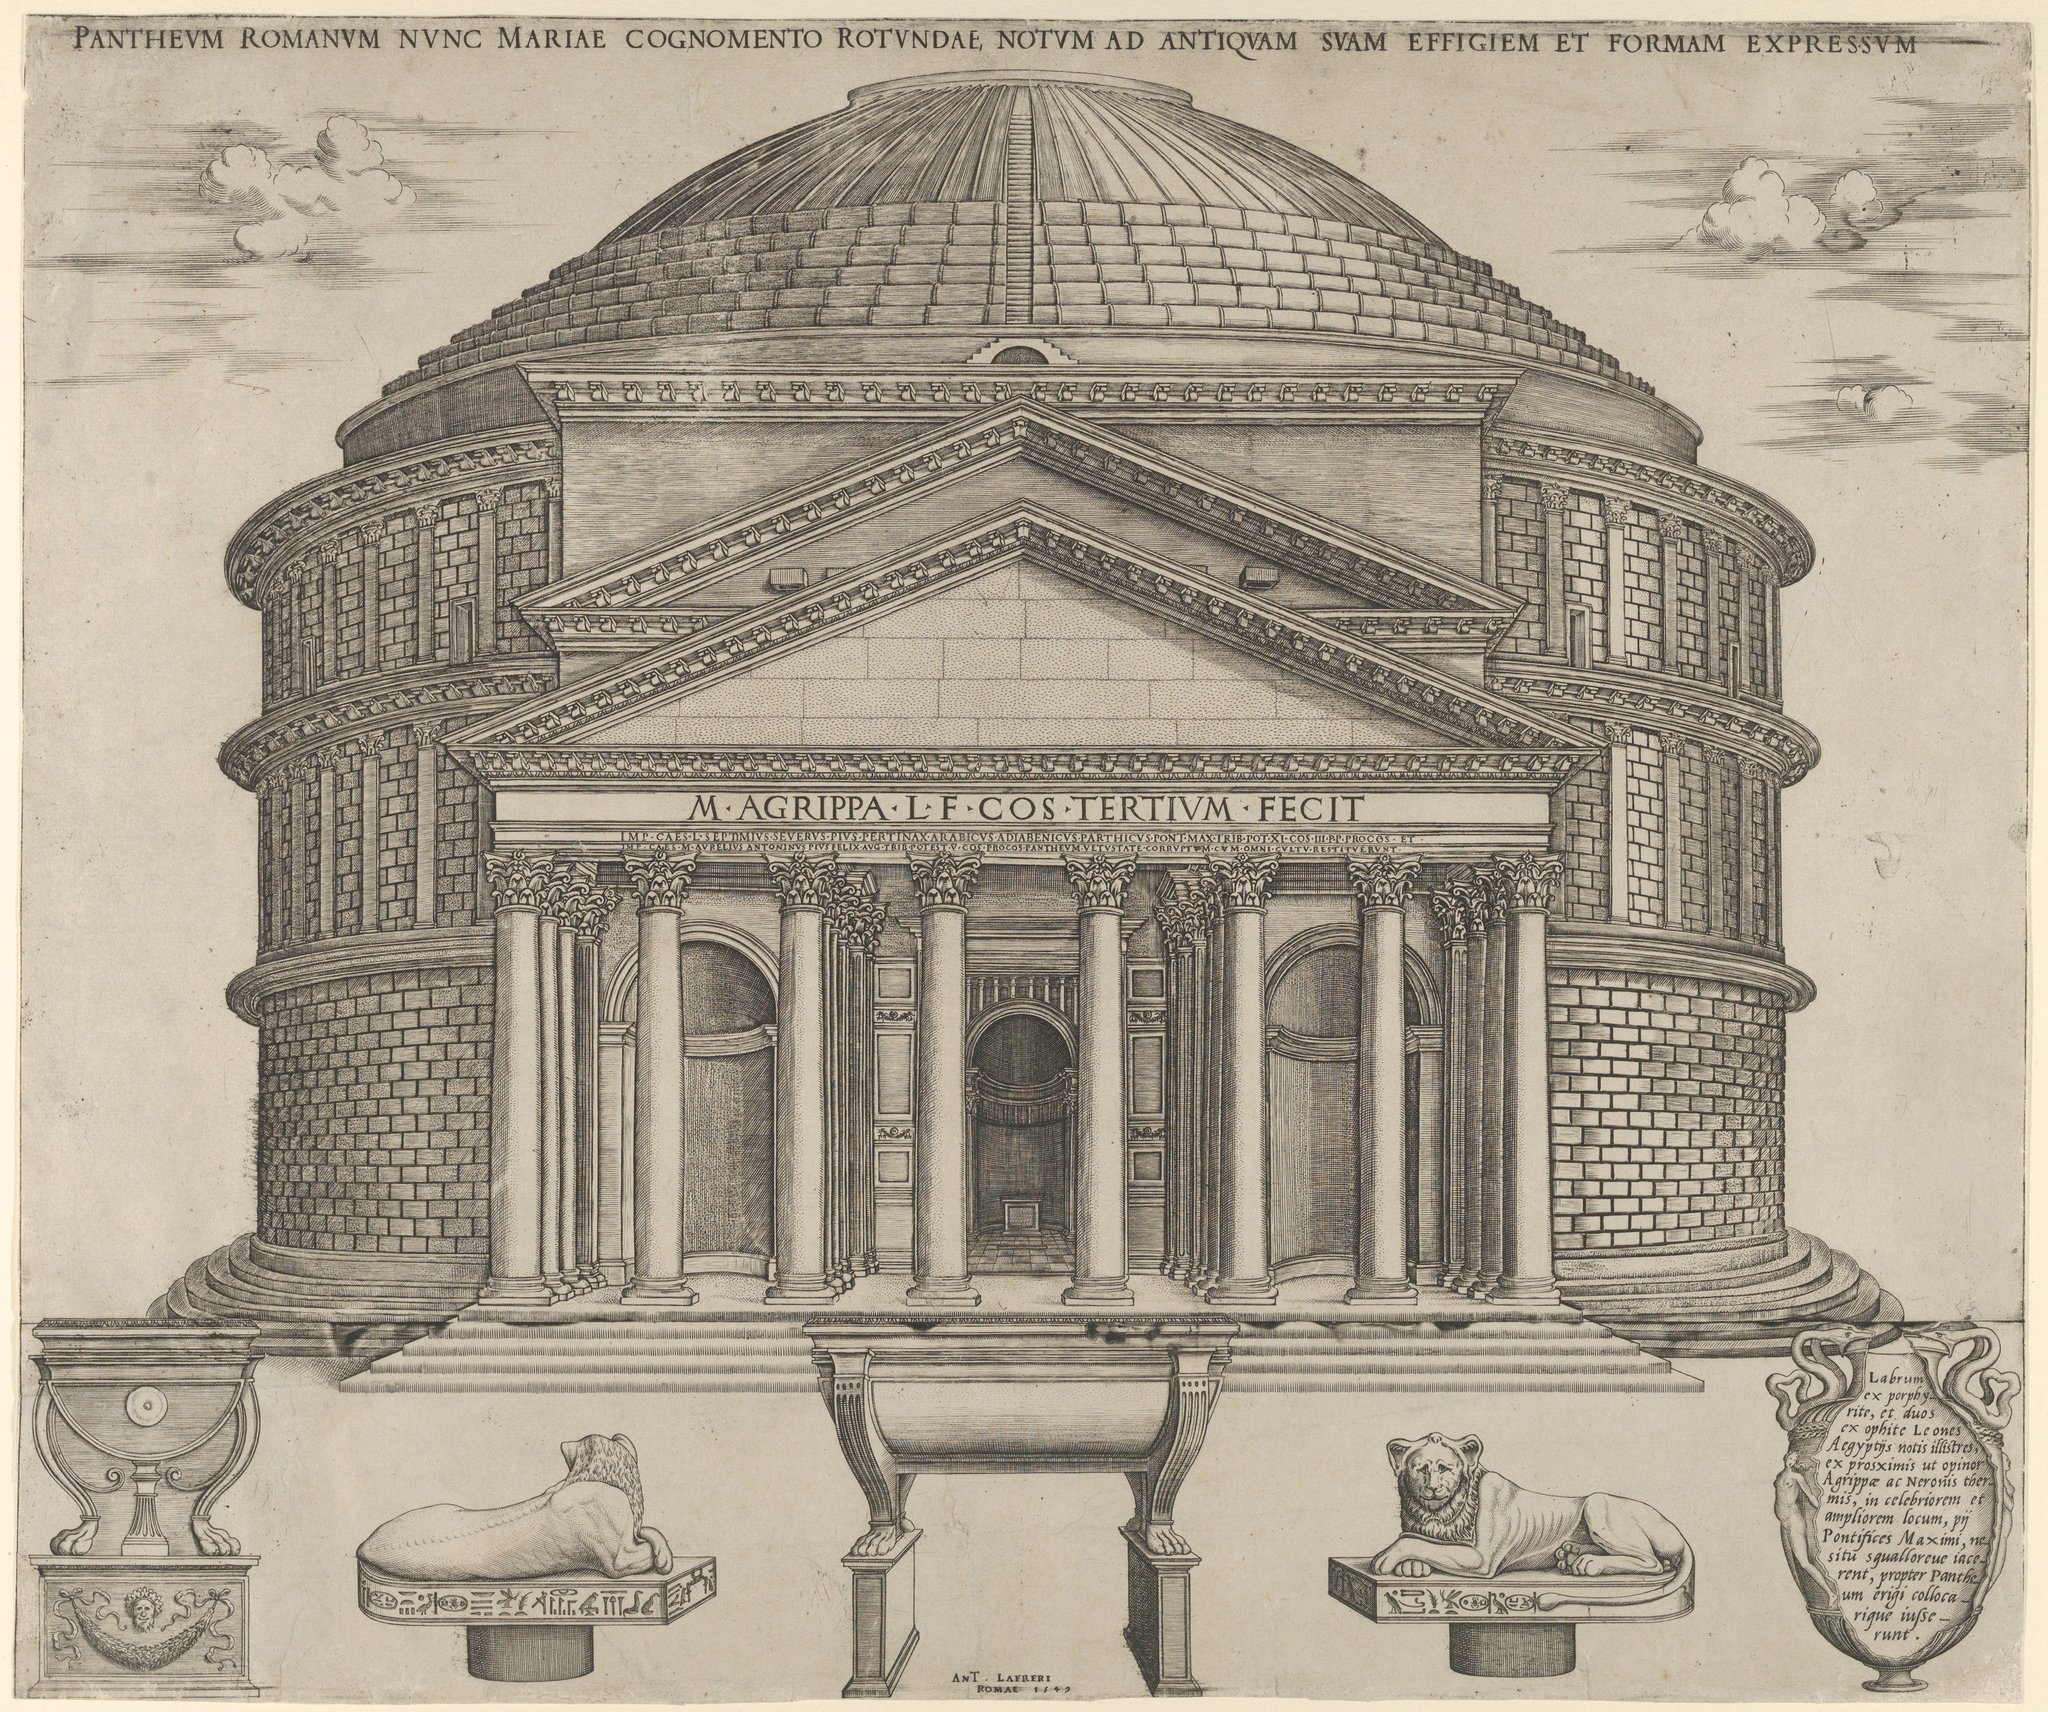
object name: print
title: Elevation of the Pantheon in Rome, reconstructed to its original form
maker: Anonymous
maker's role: artist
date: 1549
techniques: engraving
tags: temples